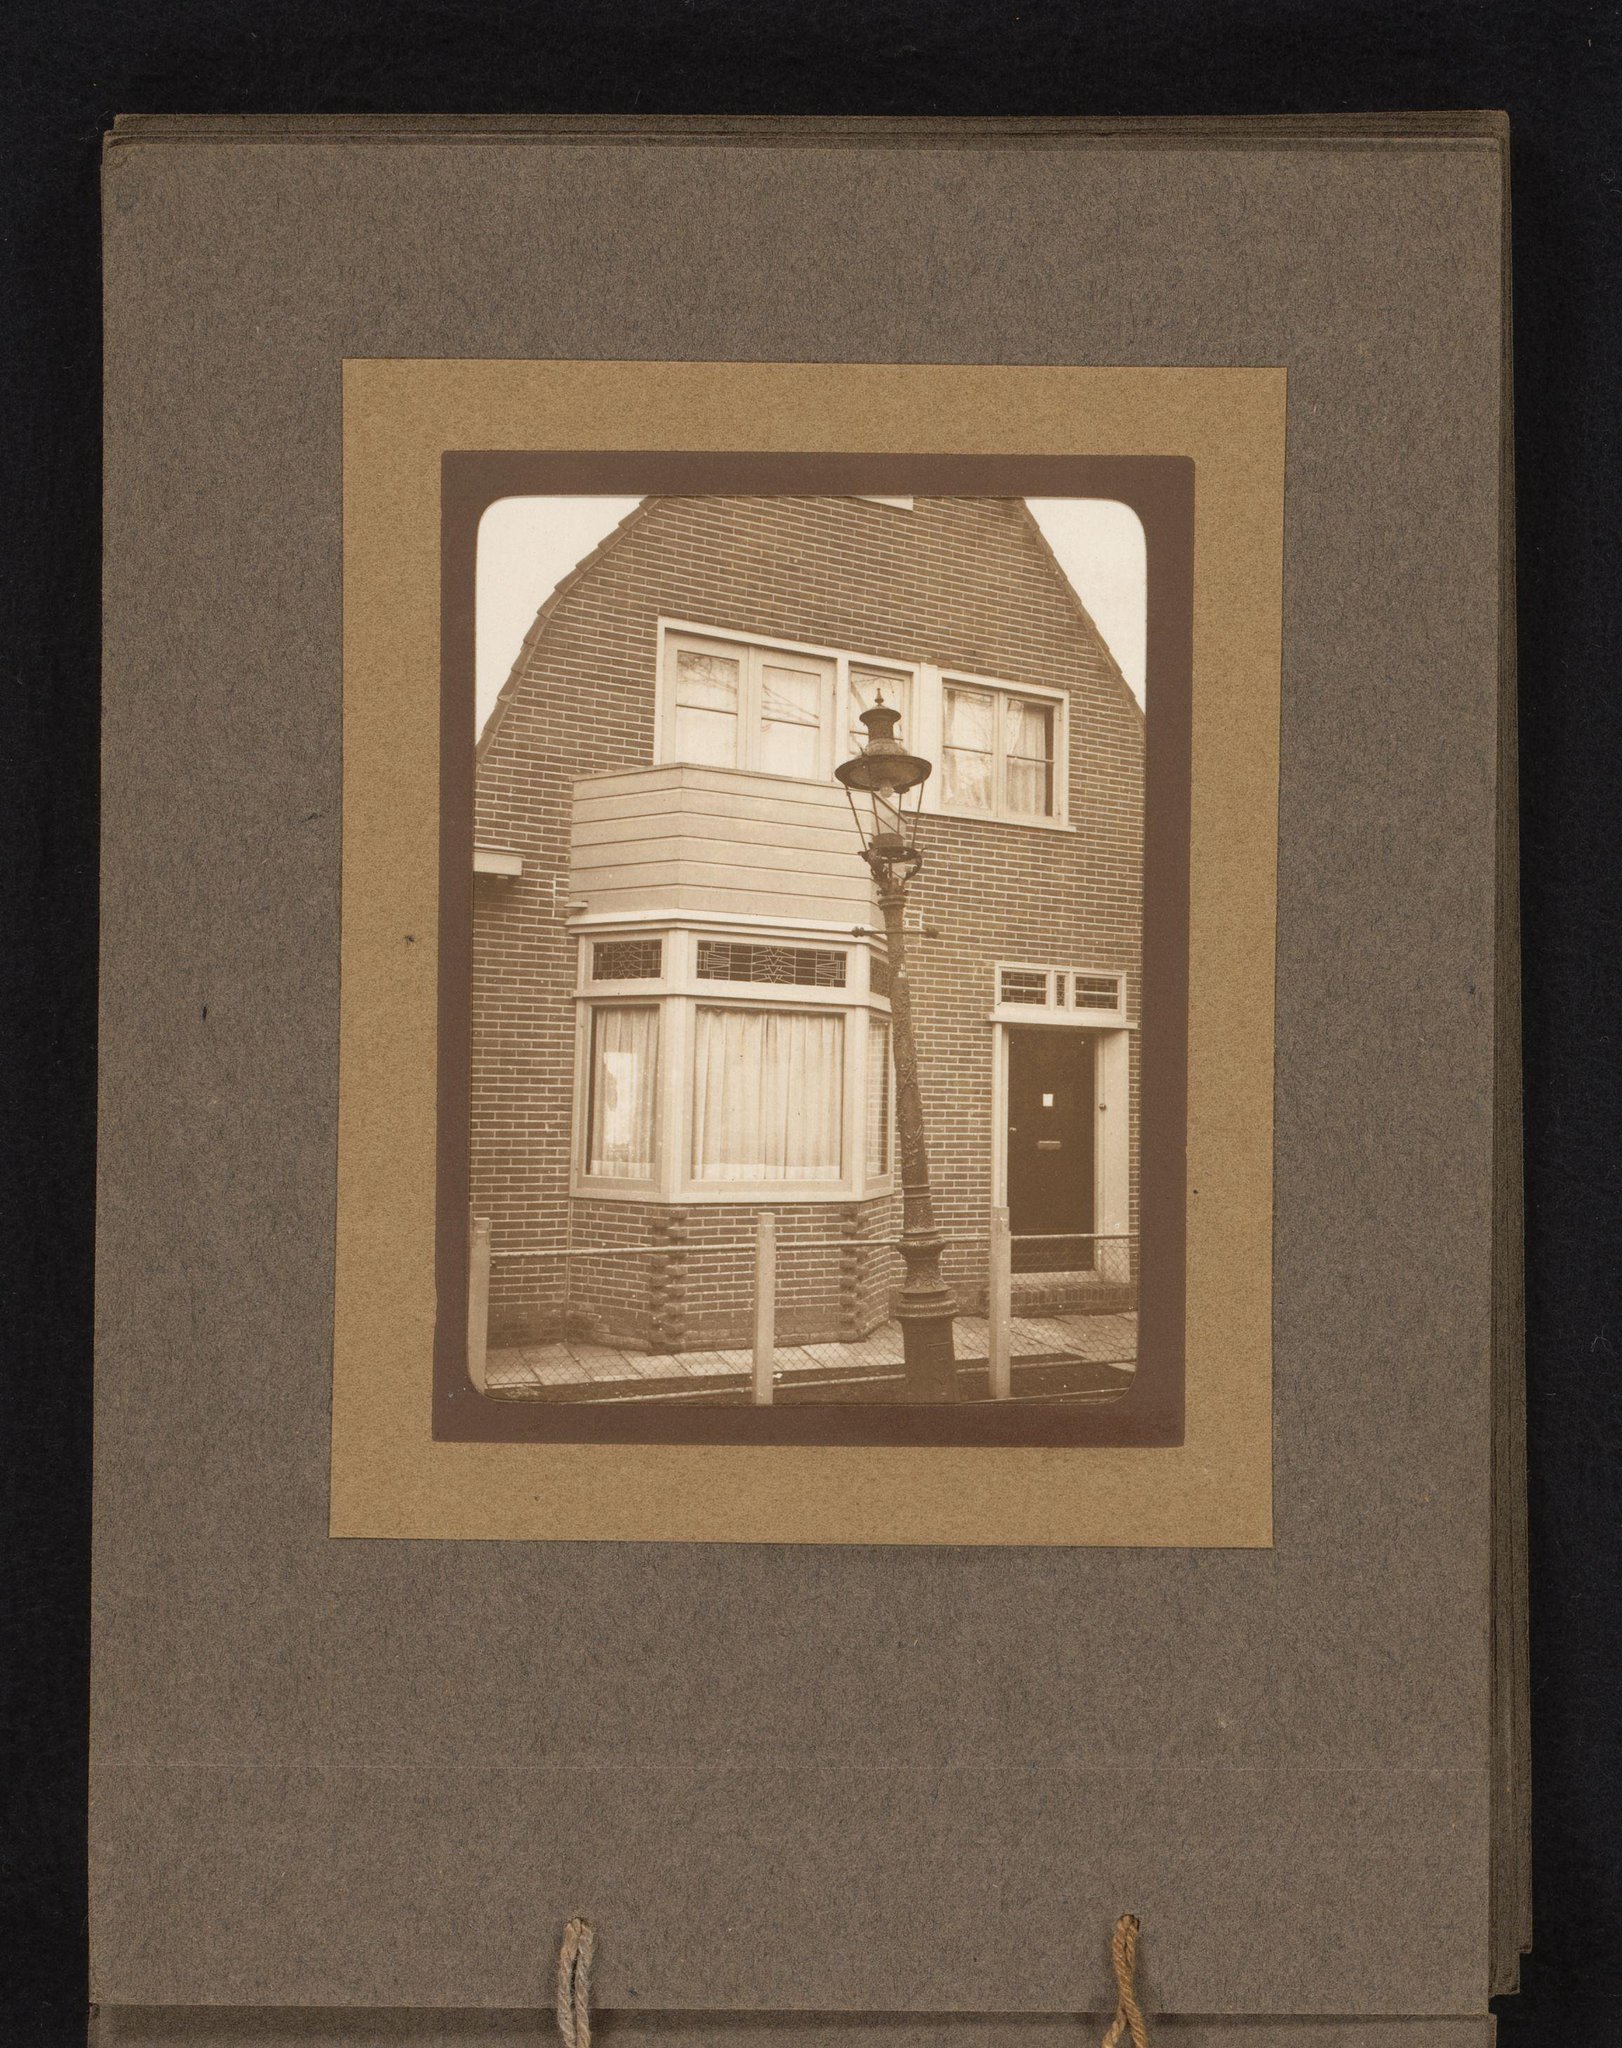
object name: album leaf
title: Straatlantaarn voor een huis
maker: Anonymous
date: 1880-1930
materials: cardboard, photographic support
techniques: collodion silver print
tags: urban housing, street lighting